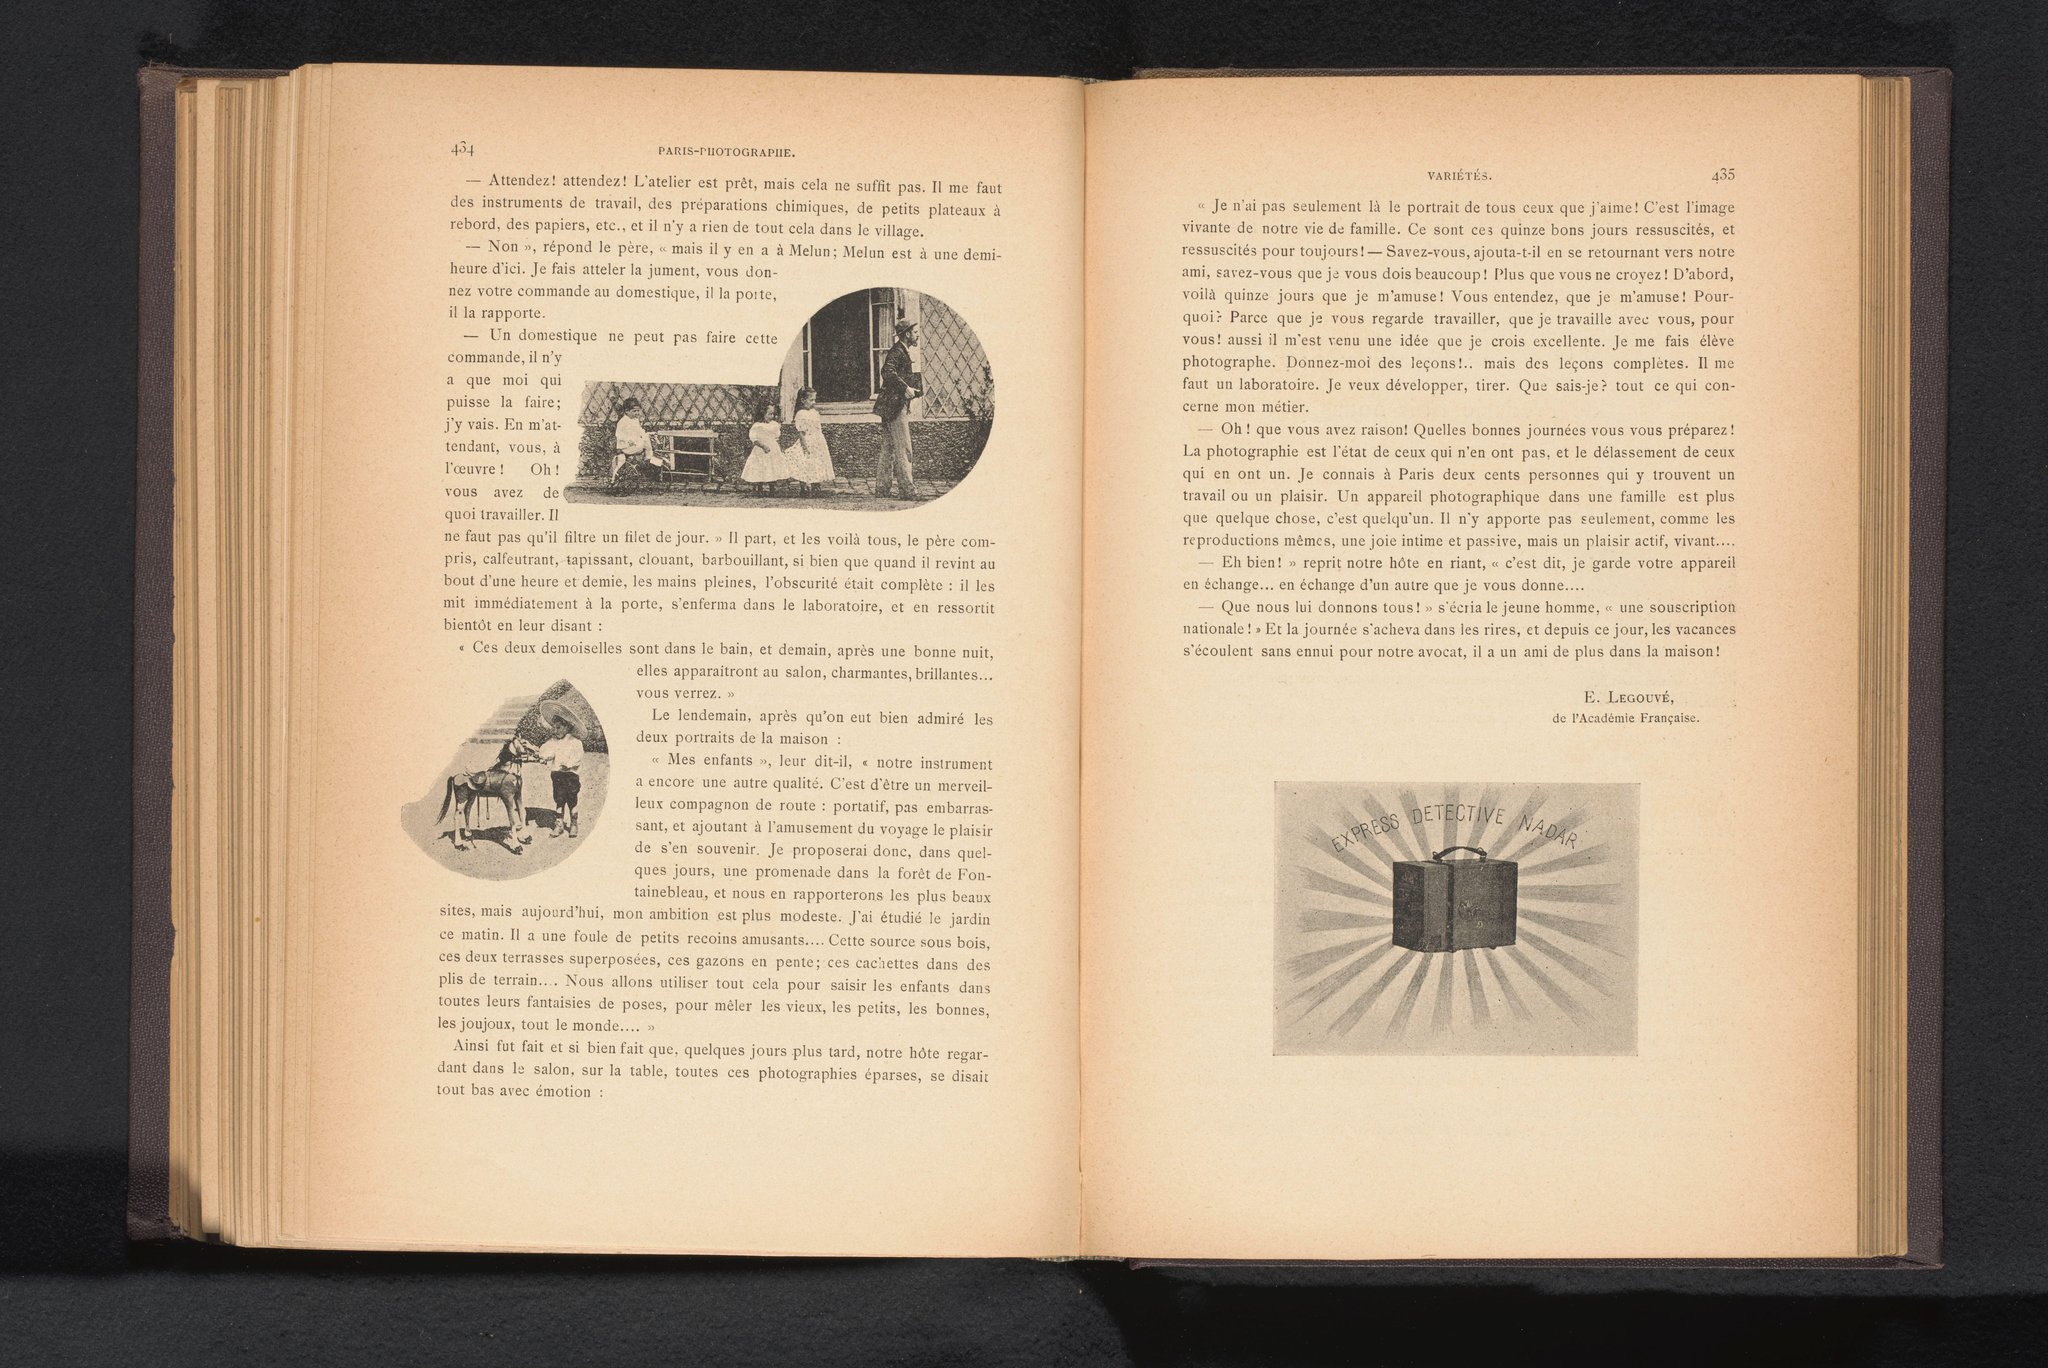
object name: photomechanical print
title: Man met drie kinderen voor een huis en een jongen met een speelgoedpaard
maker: Anonymous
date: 1883-1893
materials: paper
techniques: autotype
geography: france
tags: (playing with) toy animals